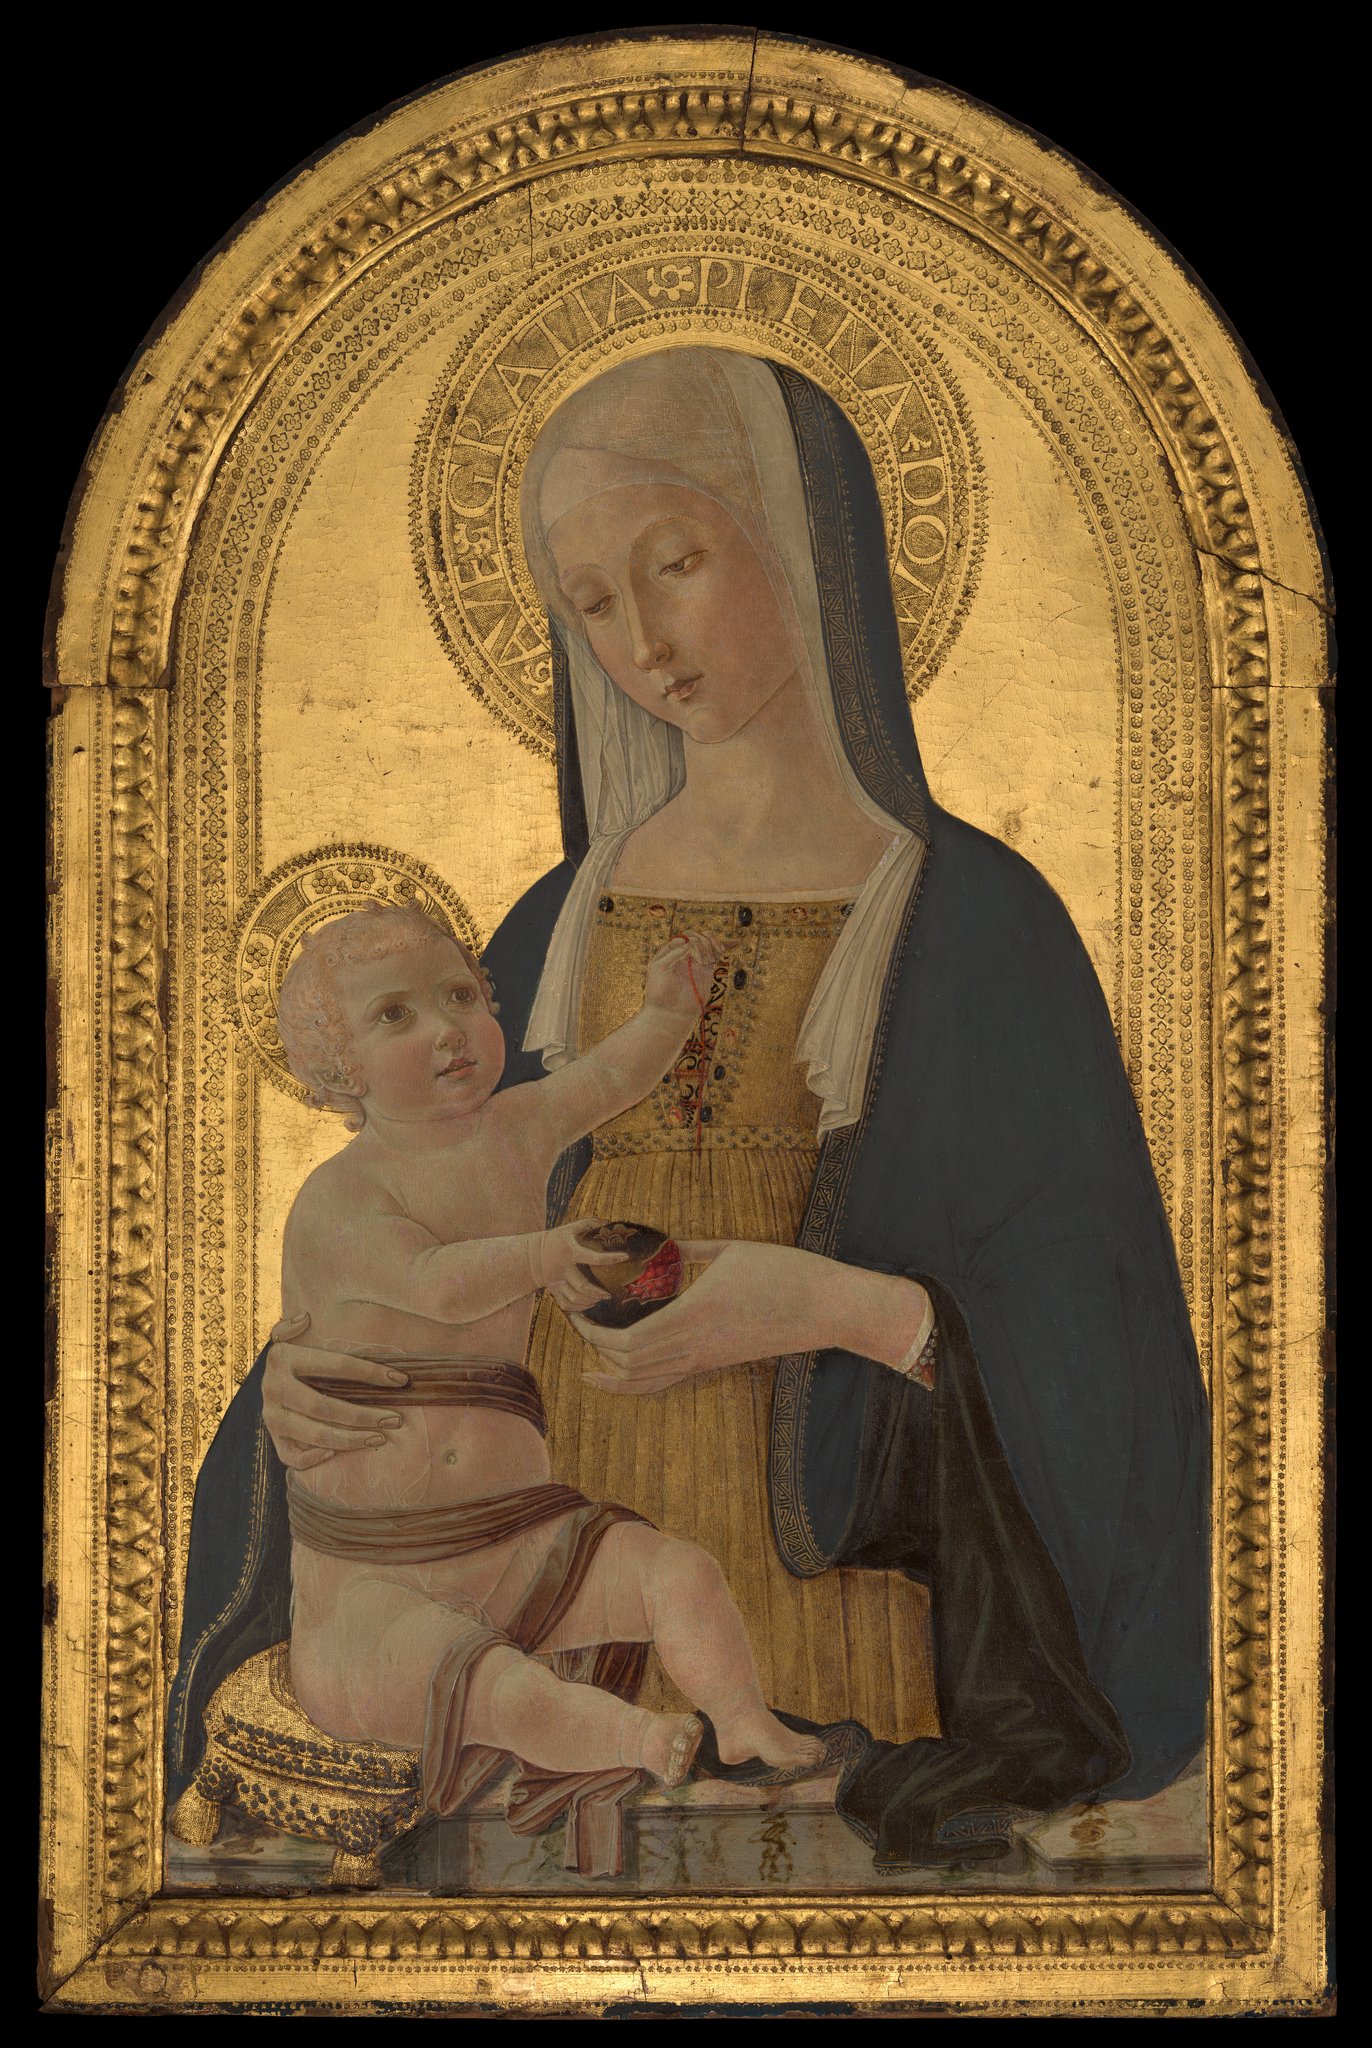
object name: painting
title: Madonna and Child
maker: benvenuto di giovanni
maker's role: artist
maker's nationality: italian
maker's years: 1436-1518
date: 1470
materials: gold leaf, paint, wood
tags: madonna and child